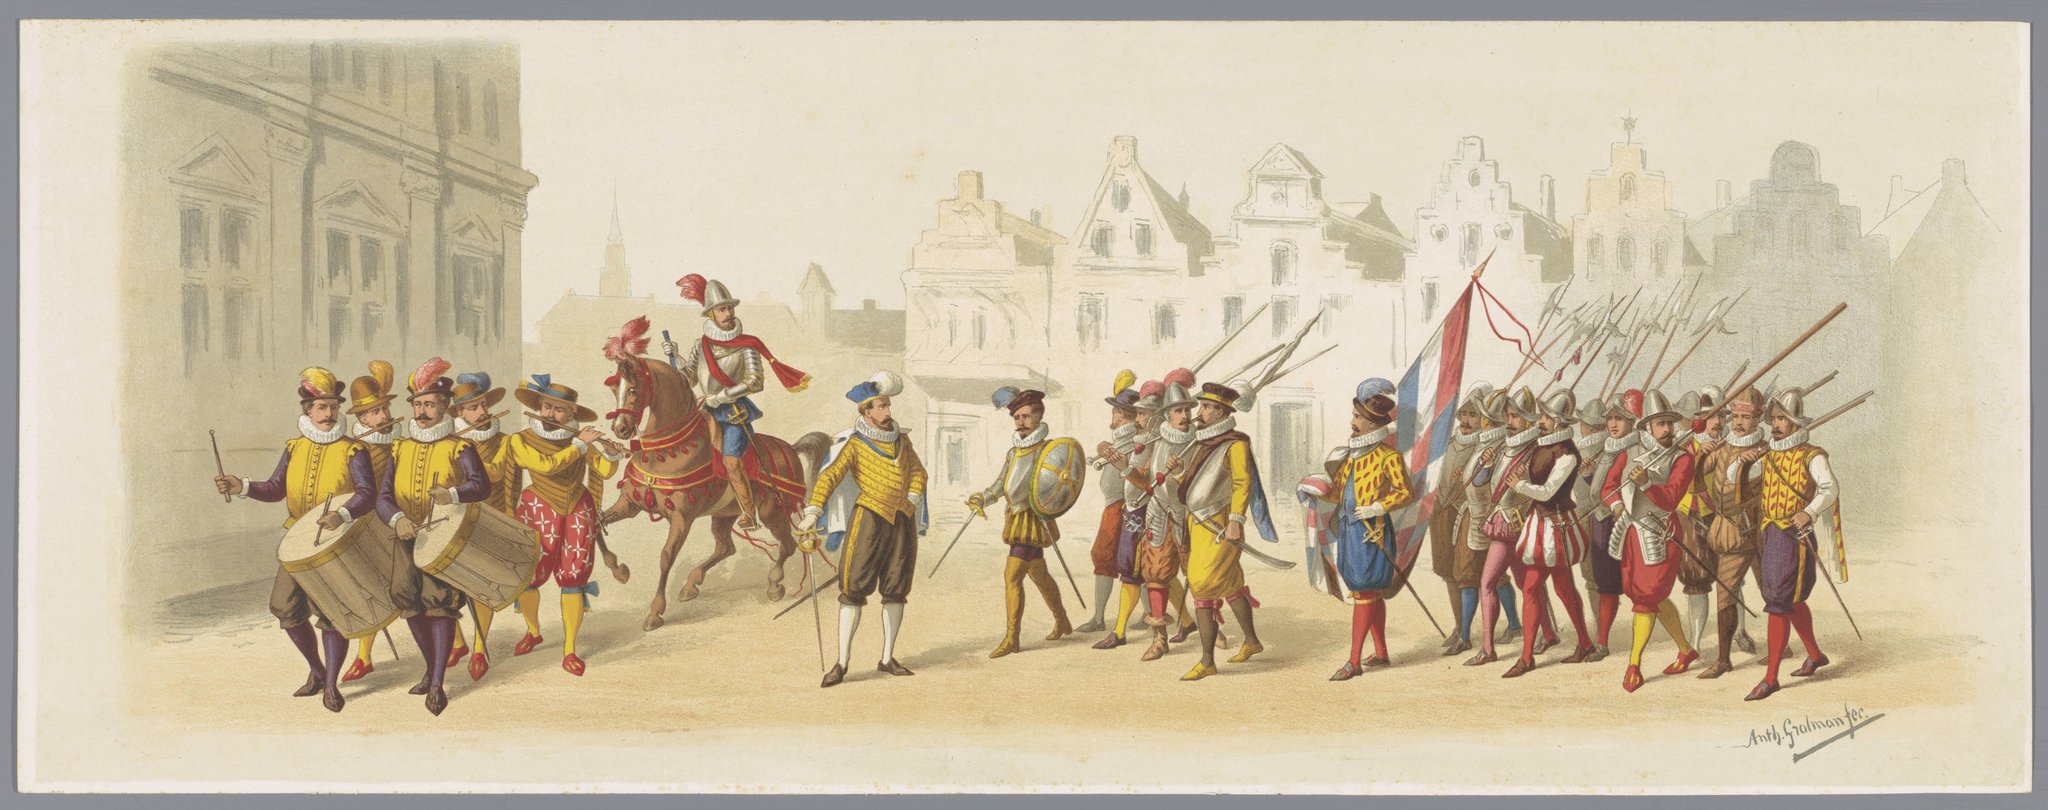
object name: print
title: Triumphelijcke Incomst vanden doorluchtighen ende hooghgheboren Aerts-hertoge Matthias, binnen die princelijcke stadt van Brussele in t'iaer ons heeren M.D.LXXVIII. den xviij dach Januarij. Gehouden door Heeren Leden van het Utrechtsche Studentencorps op den 28 Juni 1881 bij gelegenheid van het 245-jarig bestaan der Hoogeschool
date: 1881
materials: paper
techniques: chromolithography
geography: netherlands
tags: vienna, matthias van oostenrijk (rooms-duits keizer), students' pageant, costumes used in pageants, commemoration of the founding of a university, utrecht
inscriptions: collector's mark: Lugt 2228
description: Eerste plaat met een deel van de optocht. Onderdeel van de serie van zeven platen plus titelprent en verklaring van de gekostumeerde optocht door de studenten van de Utrechtse Hogeschool op 28 juni 1881 bij de viering van het 245-jarig bestaan van de Hogeschool. Voorgesteld is de intocht van aartshertog Matthias in Brusssel op 18 januari 1578.